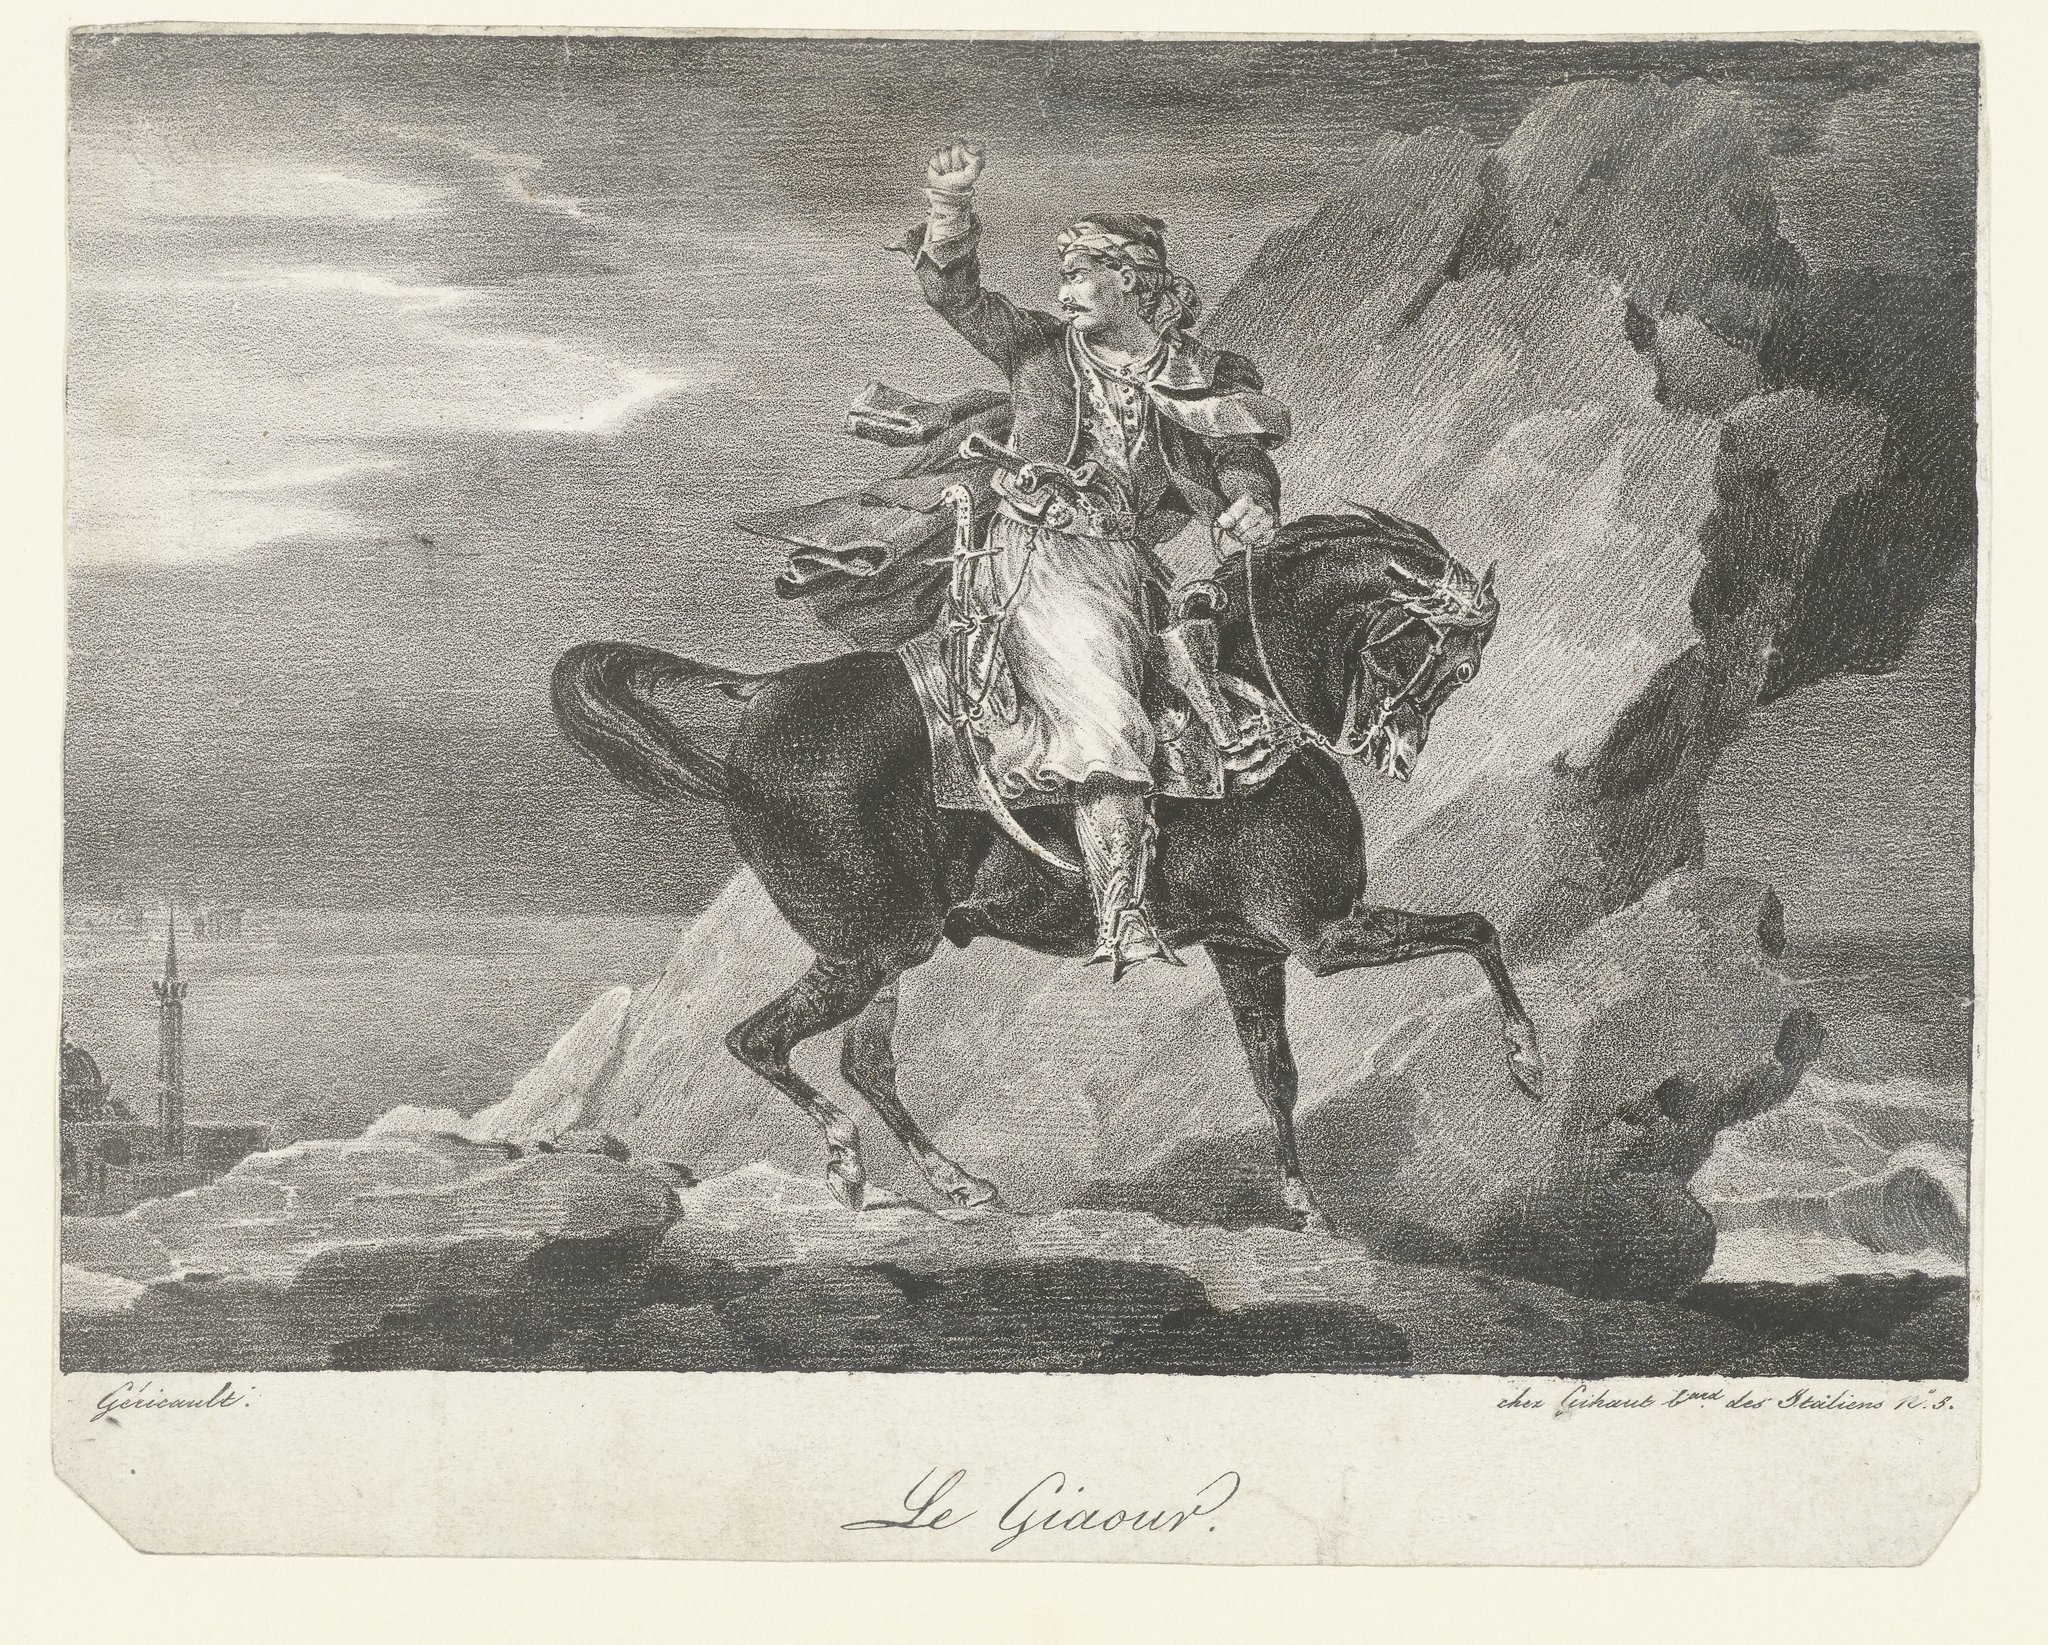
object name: print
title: Suite de sept petites pièces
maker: théodore géricault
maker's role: draughtsman, print maker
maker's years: 1791-1824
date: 1819-1823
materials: paper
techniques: lithograph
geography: paris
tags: riding a horse, ass, or mule; rider, horseman, asiatic races and peoples: turks, literary characters and objects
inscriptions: collector's mark: Lugt 2228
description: De Giaour, een Turkse niet-moslim, als strijder te paard. Hij kijkt achterom en houdt zijn vuist gebald in de lucht. Op de achtergrond een moskee.